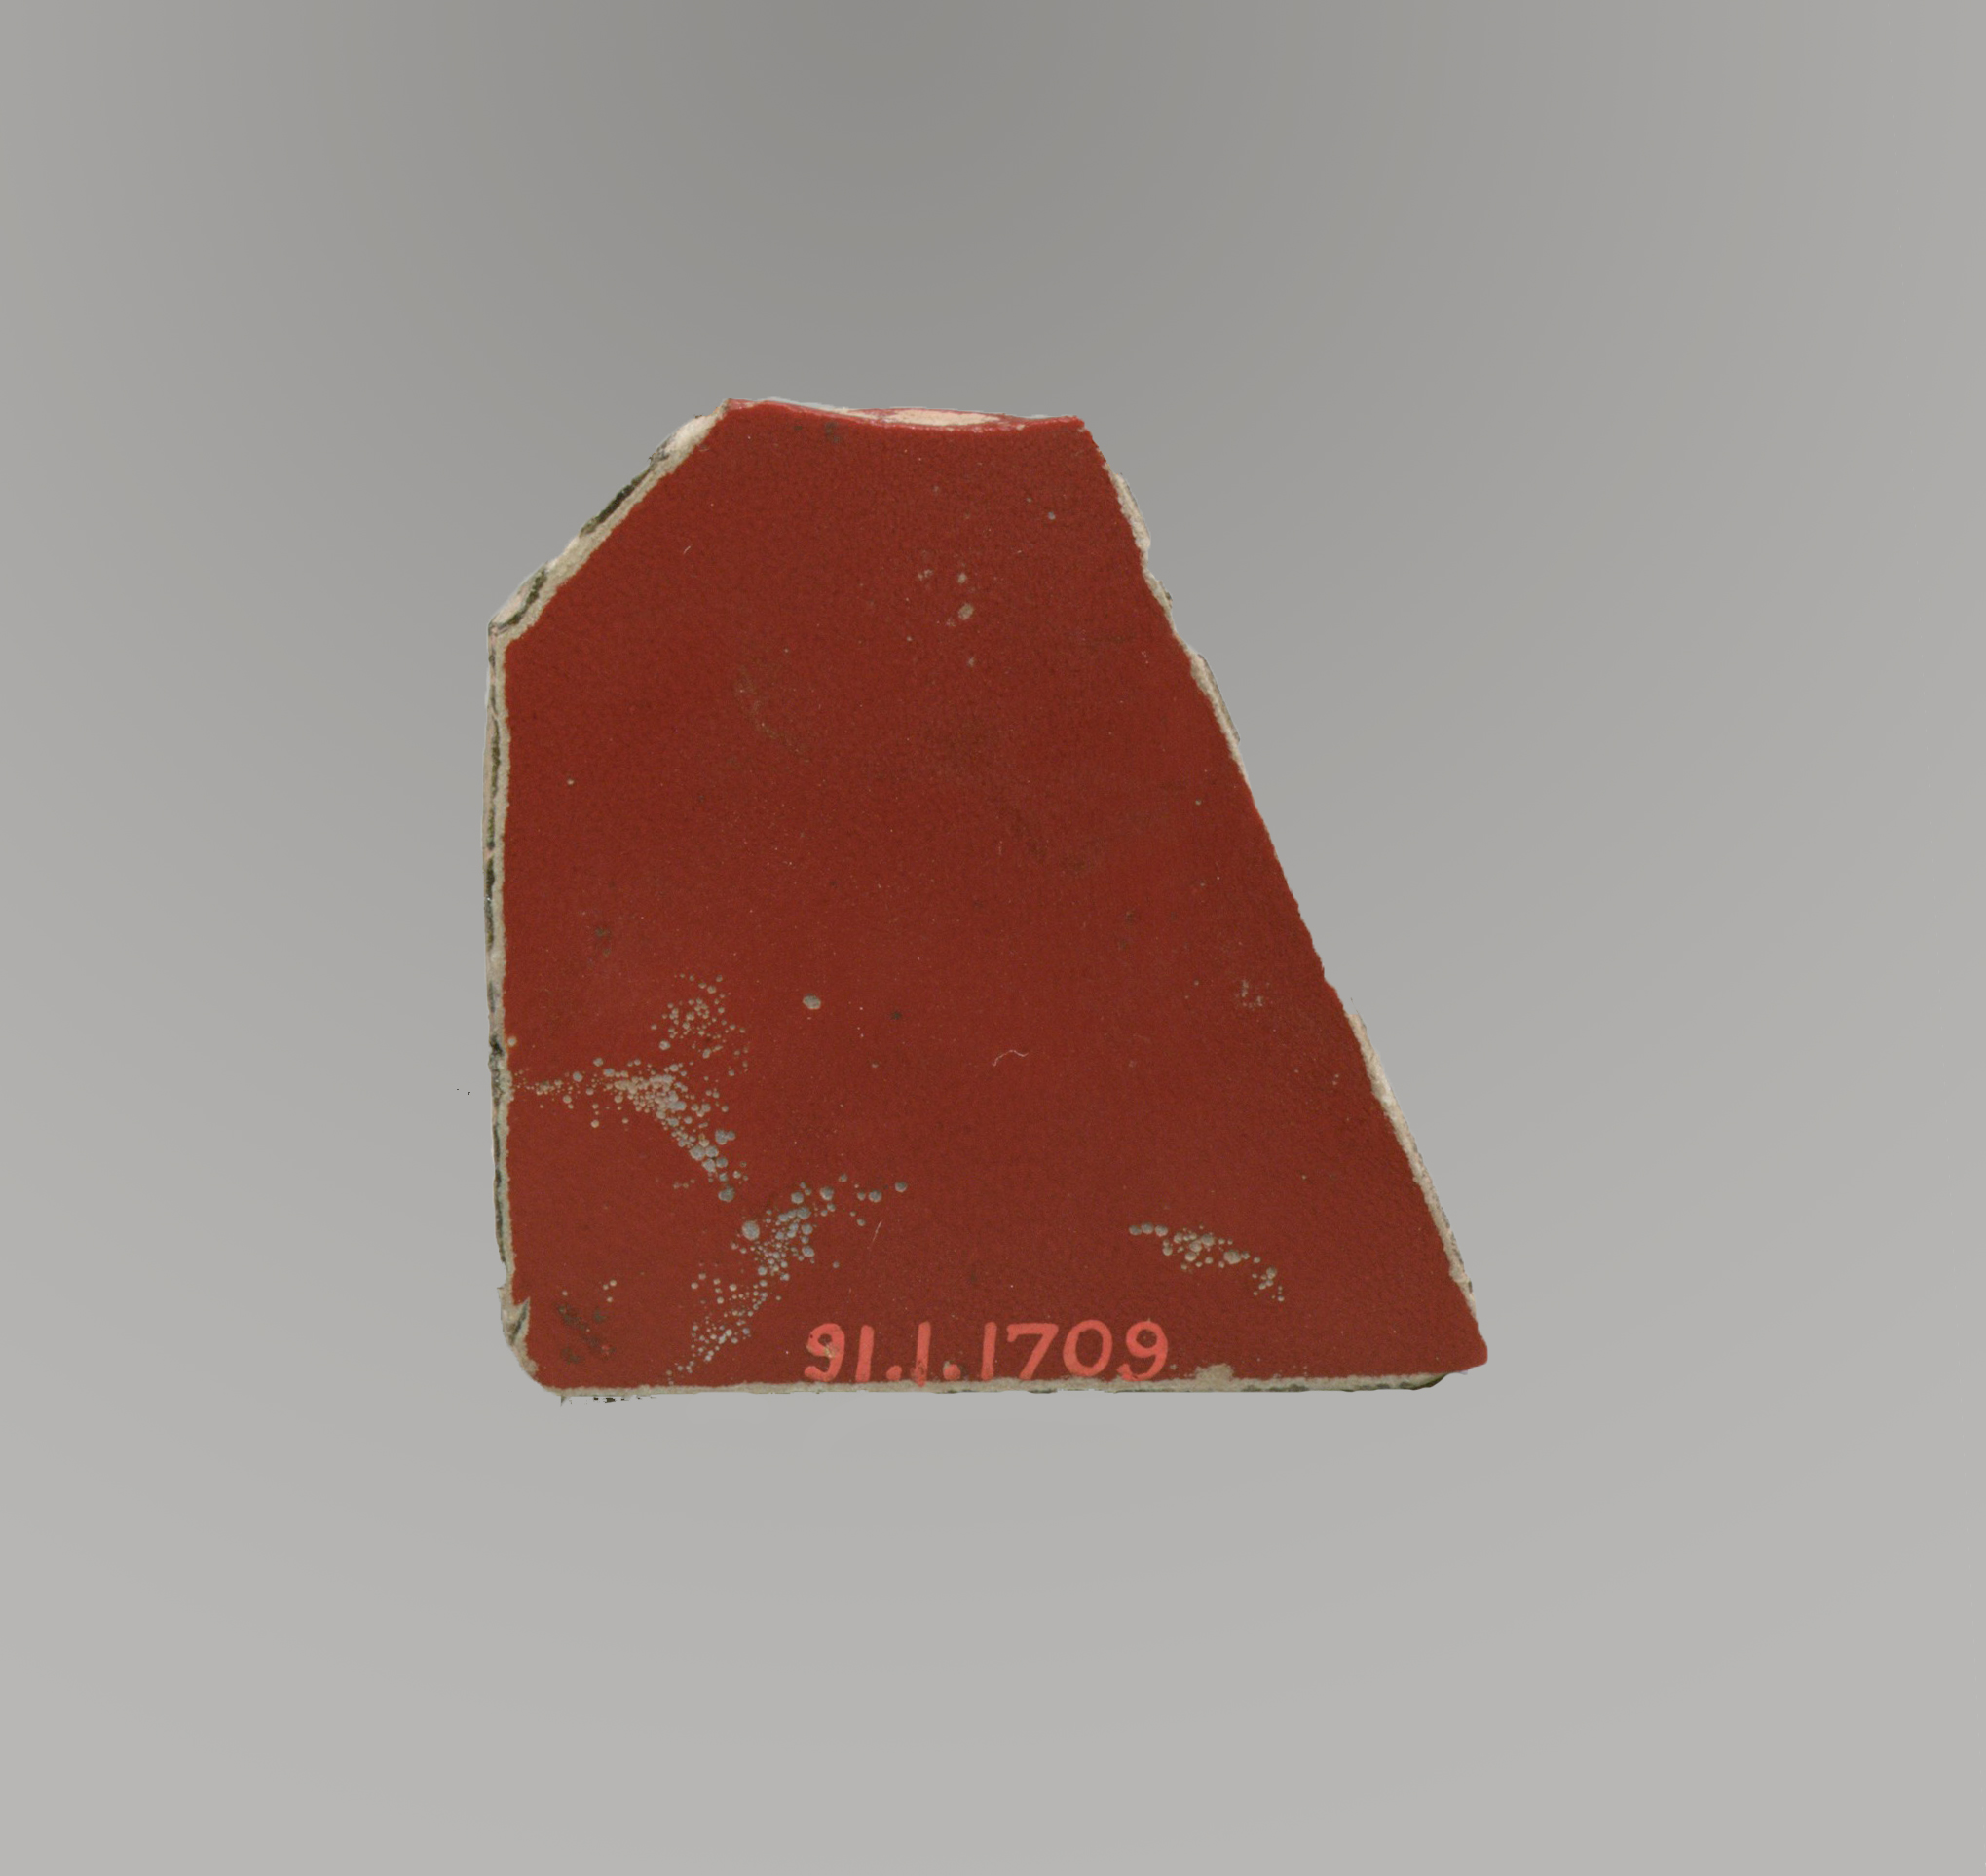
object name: fragment, monochrome, opaque red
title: Glass monochrome inlay fragment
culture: roman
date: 1-50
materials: glass